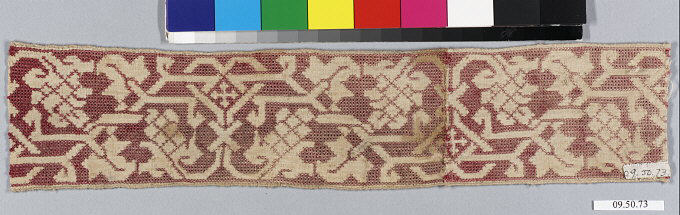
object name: border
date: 1501-1700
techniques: embroidery